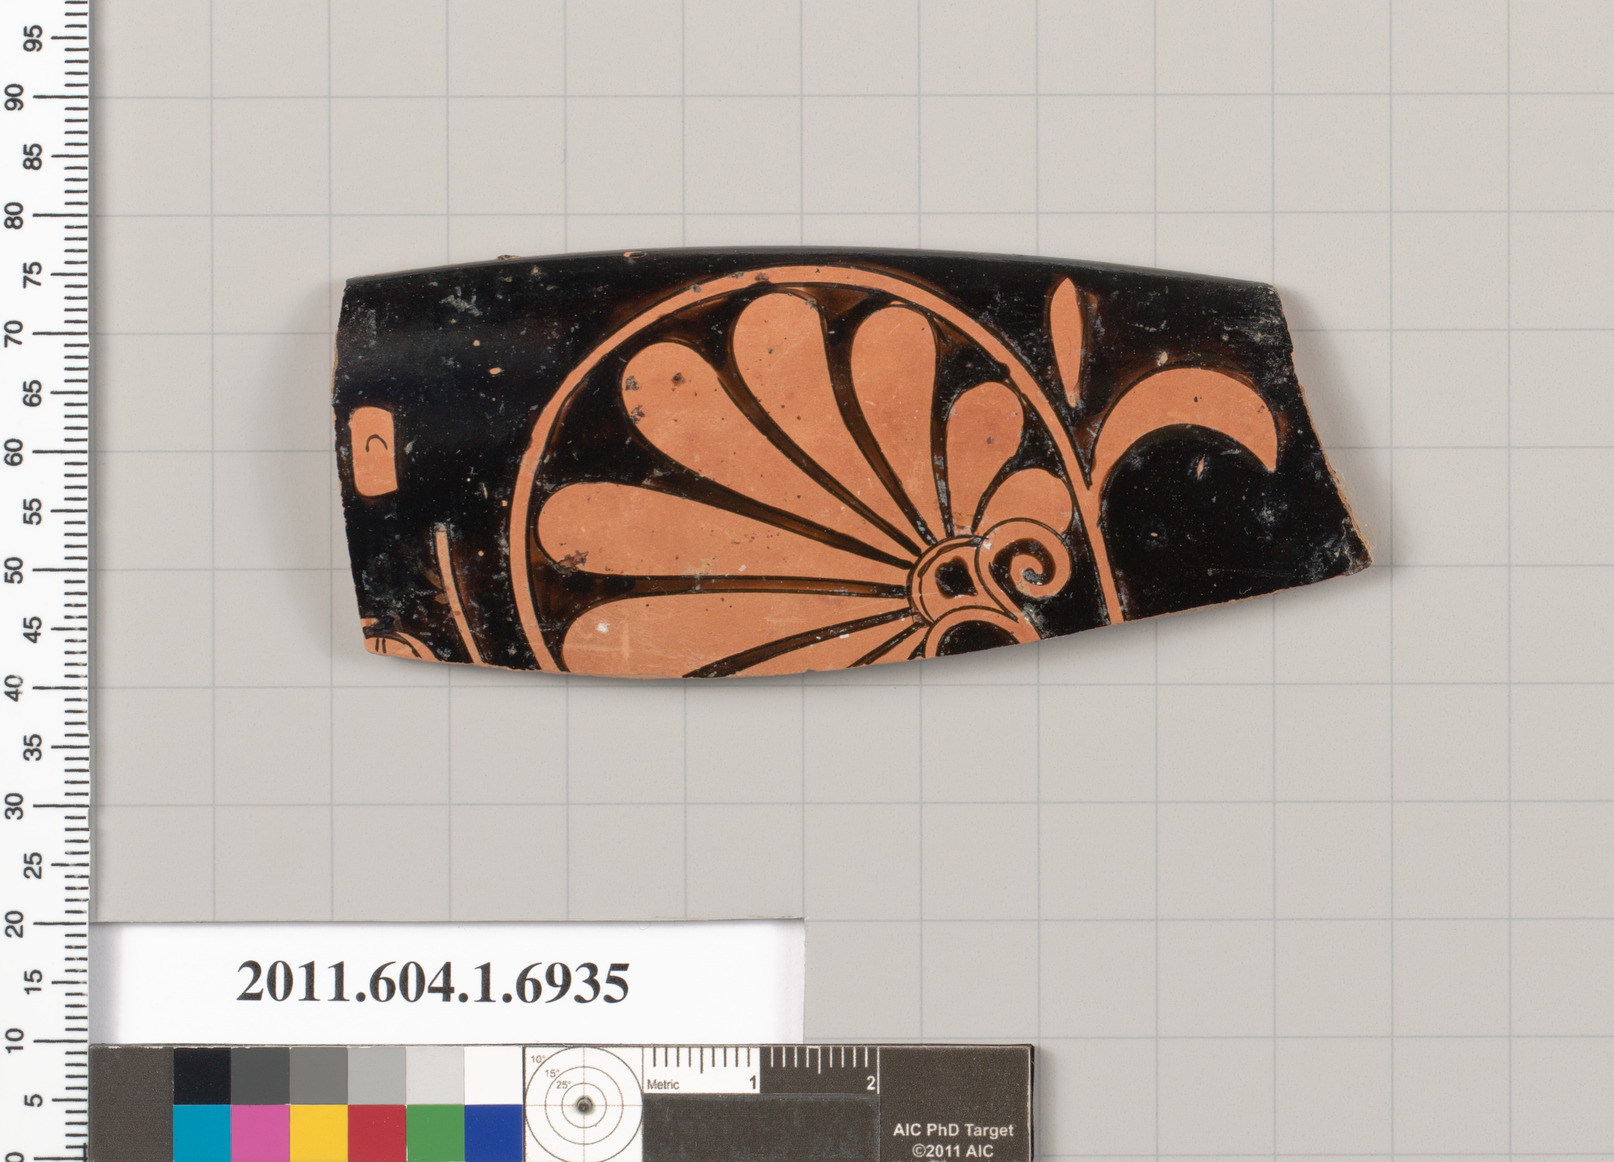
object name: kylix fragment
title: Terracotta rim fragment of a kylix (drinking cup)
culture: greek, attic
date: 490-470 BCE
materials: terracotta